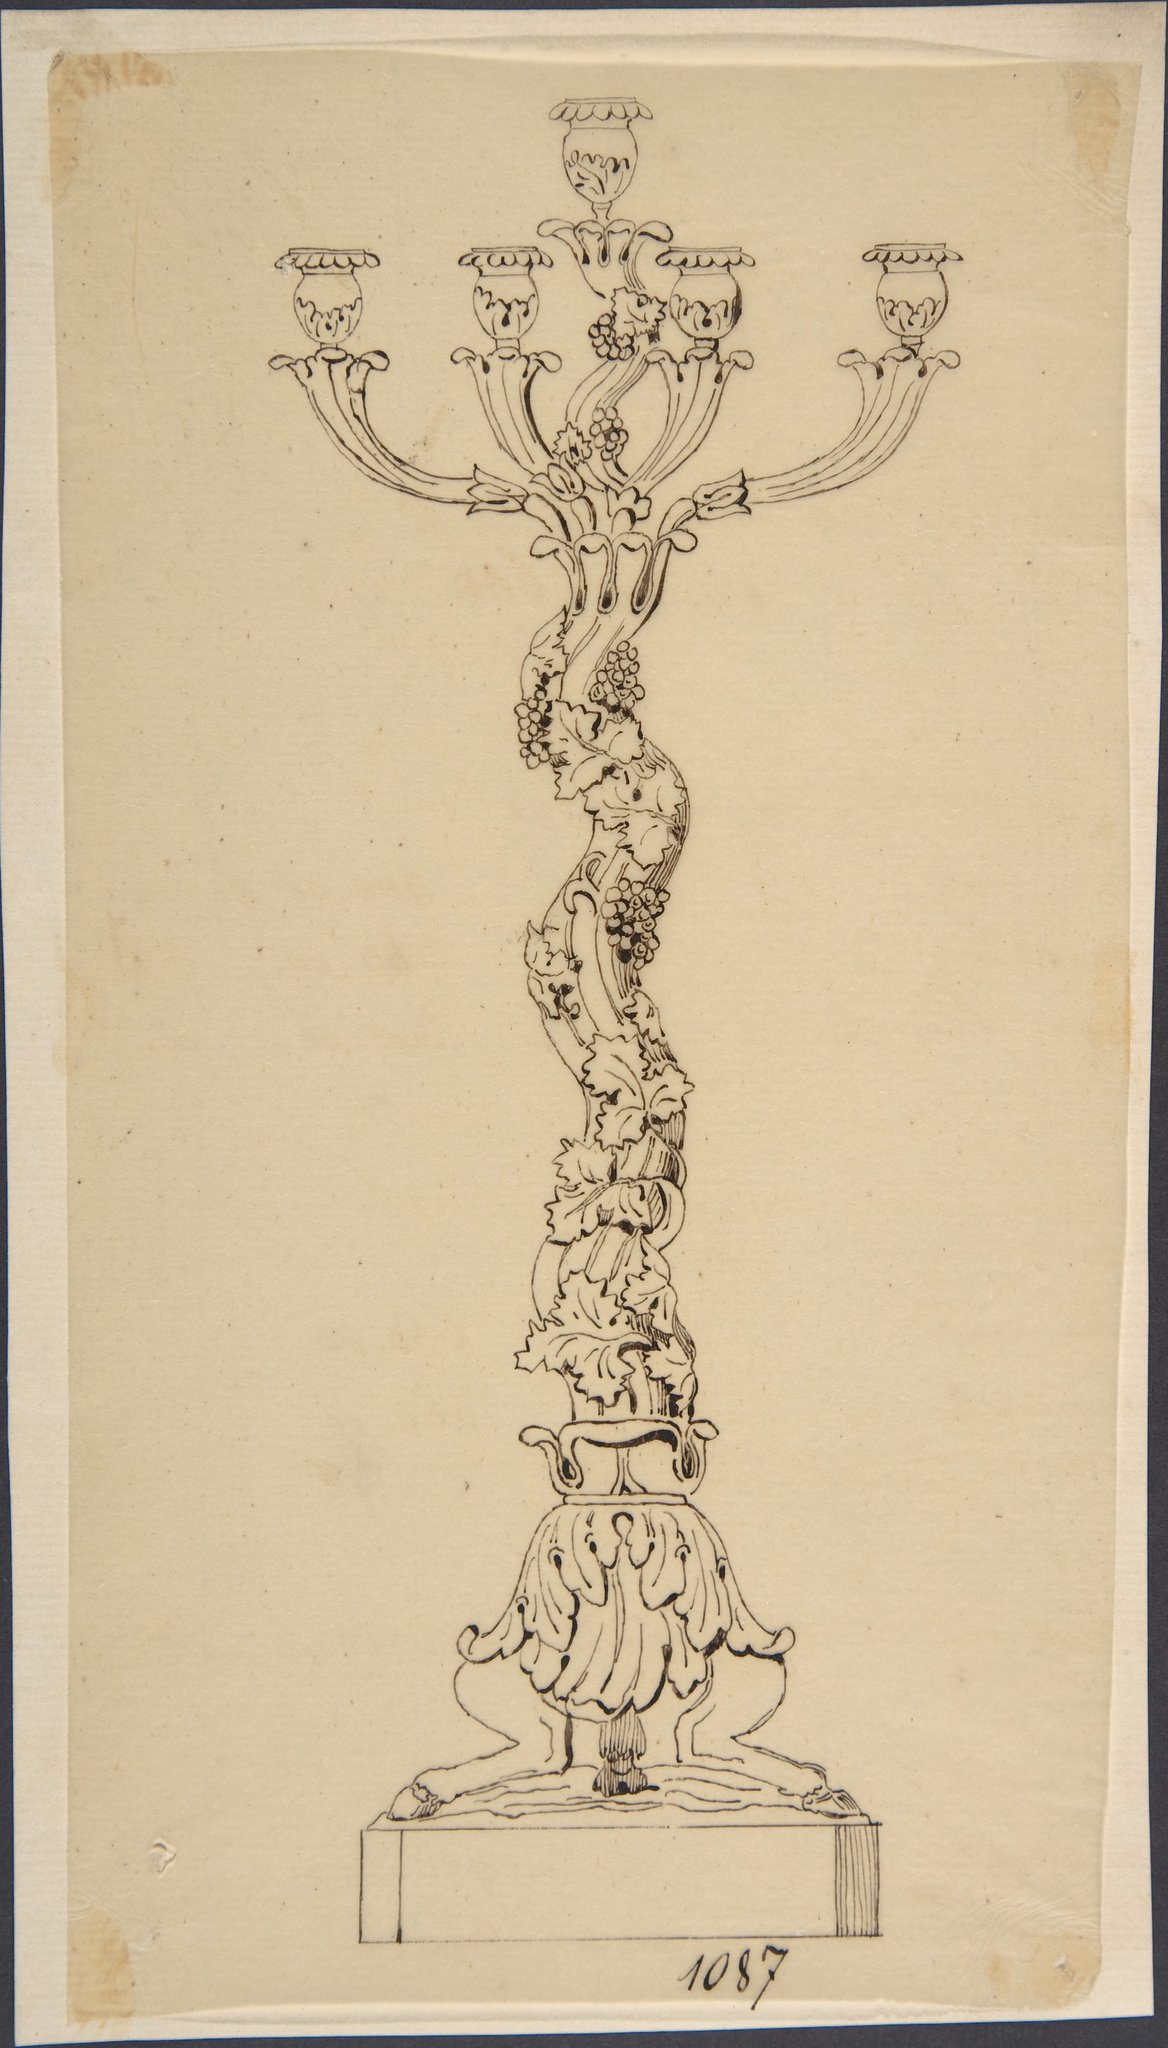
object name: drawing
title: Design for a Candelabra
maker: anonymous, french, 19th century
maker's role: artist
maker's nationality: french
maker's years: 1800-1900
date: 1801-1900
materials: ink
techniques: pen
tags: candelabra